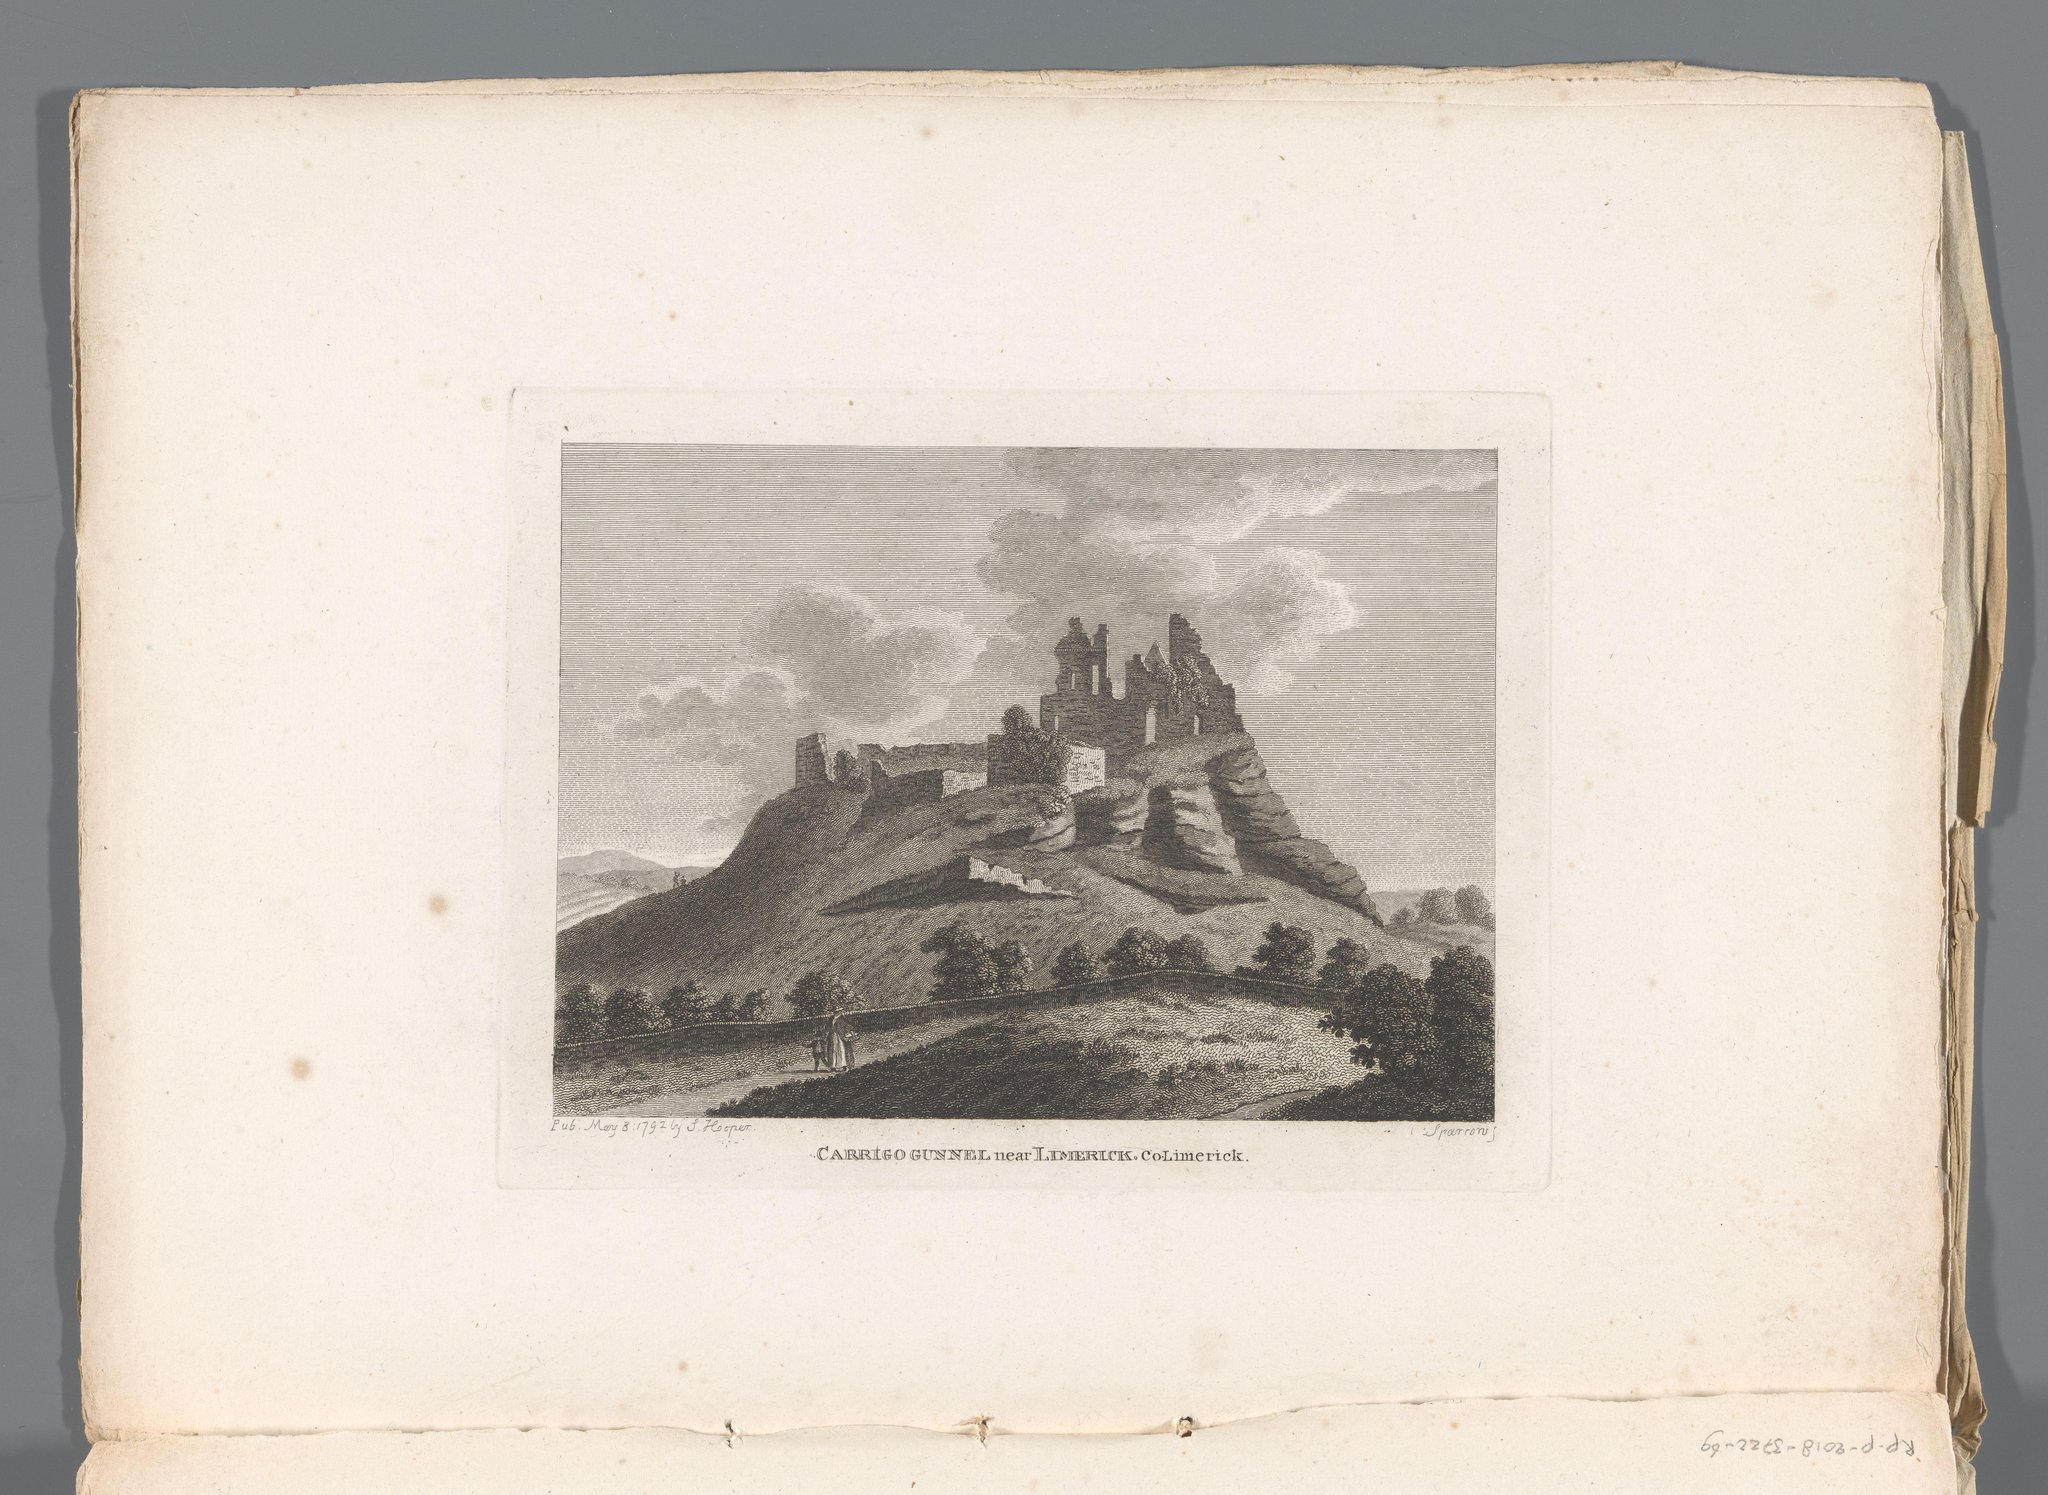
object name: print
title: Carritgo Gunnel near Limerick. Co.Limerick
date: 1792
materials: paper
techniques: etching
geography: london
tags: city-view, and landscape with man-made constructions, landscape with ruins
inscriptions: date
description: Prent verschenen in: Grose, Francis. The antiquities of Ireland. Londen: S. Hooper, 1795, dl. 2.